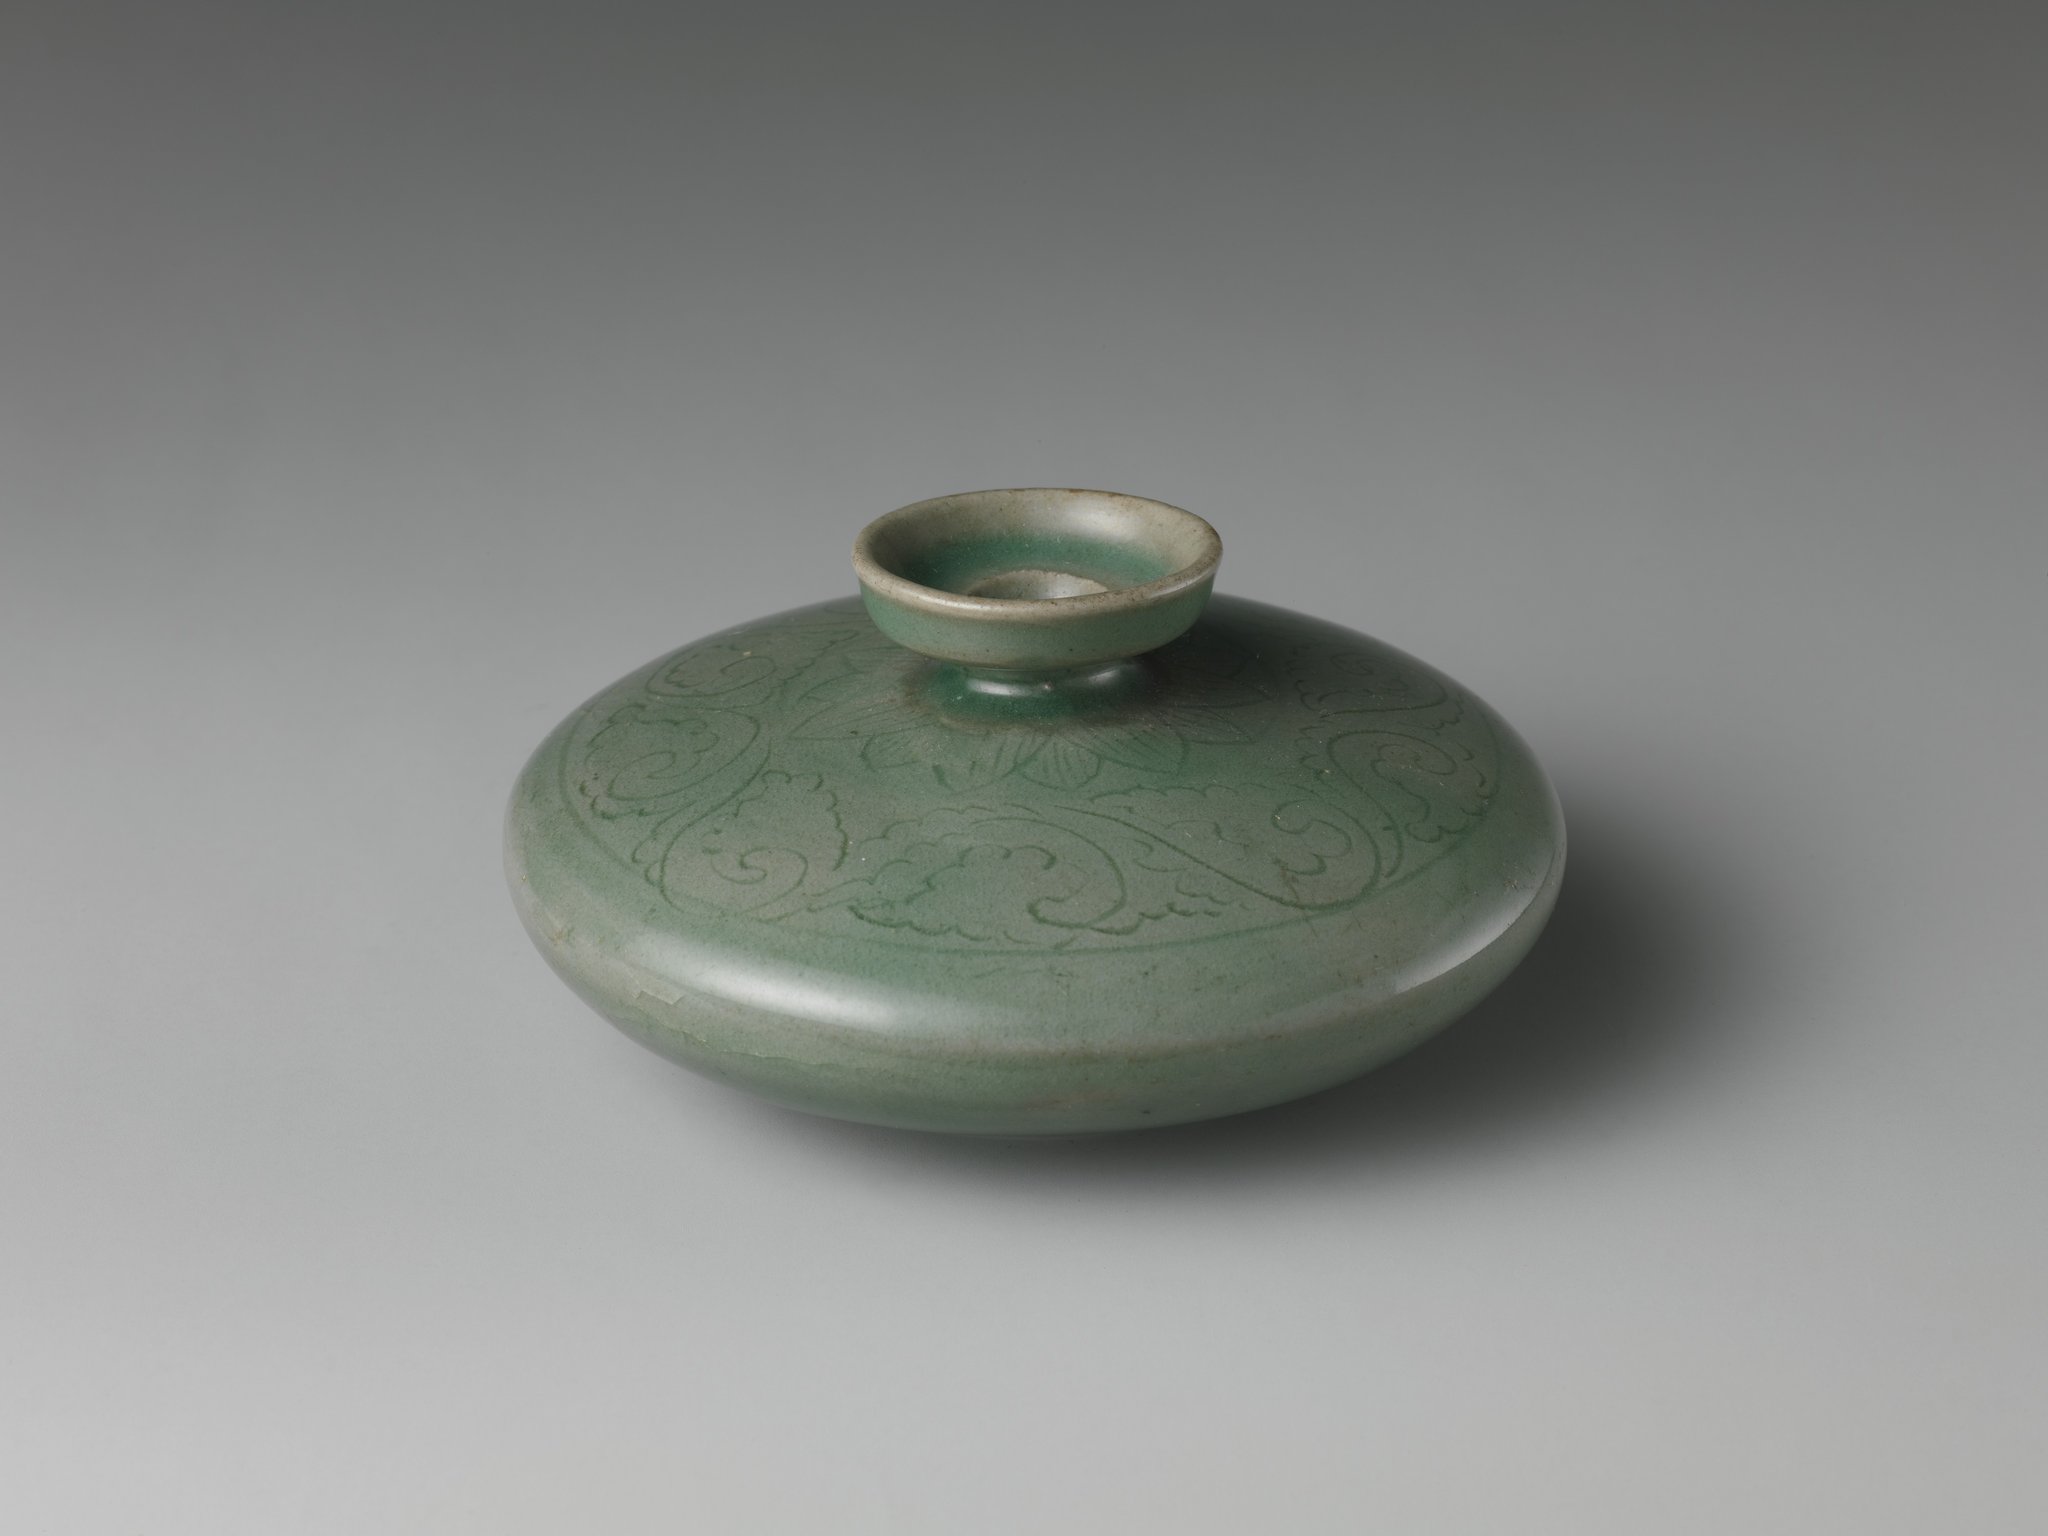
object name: oil bottle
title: Oil bottle decorated with floral scrolls and lotus petals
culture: korean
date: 1101-1200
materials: ceramic glaze, glaze, stoneware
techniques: incising